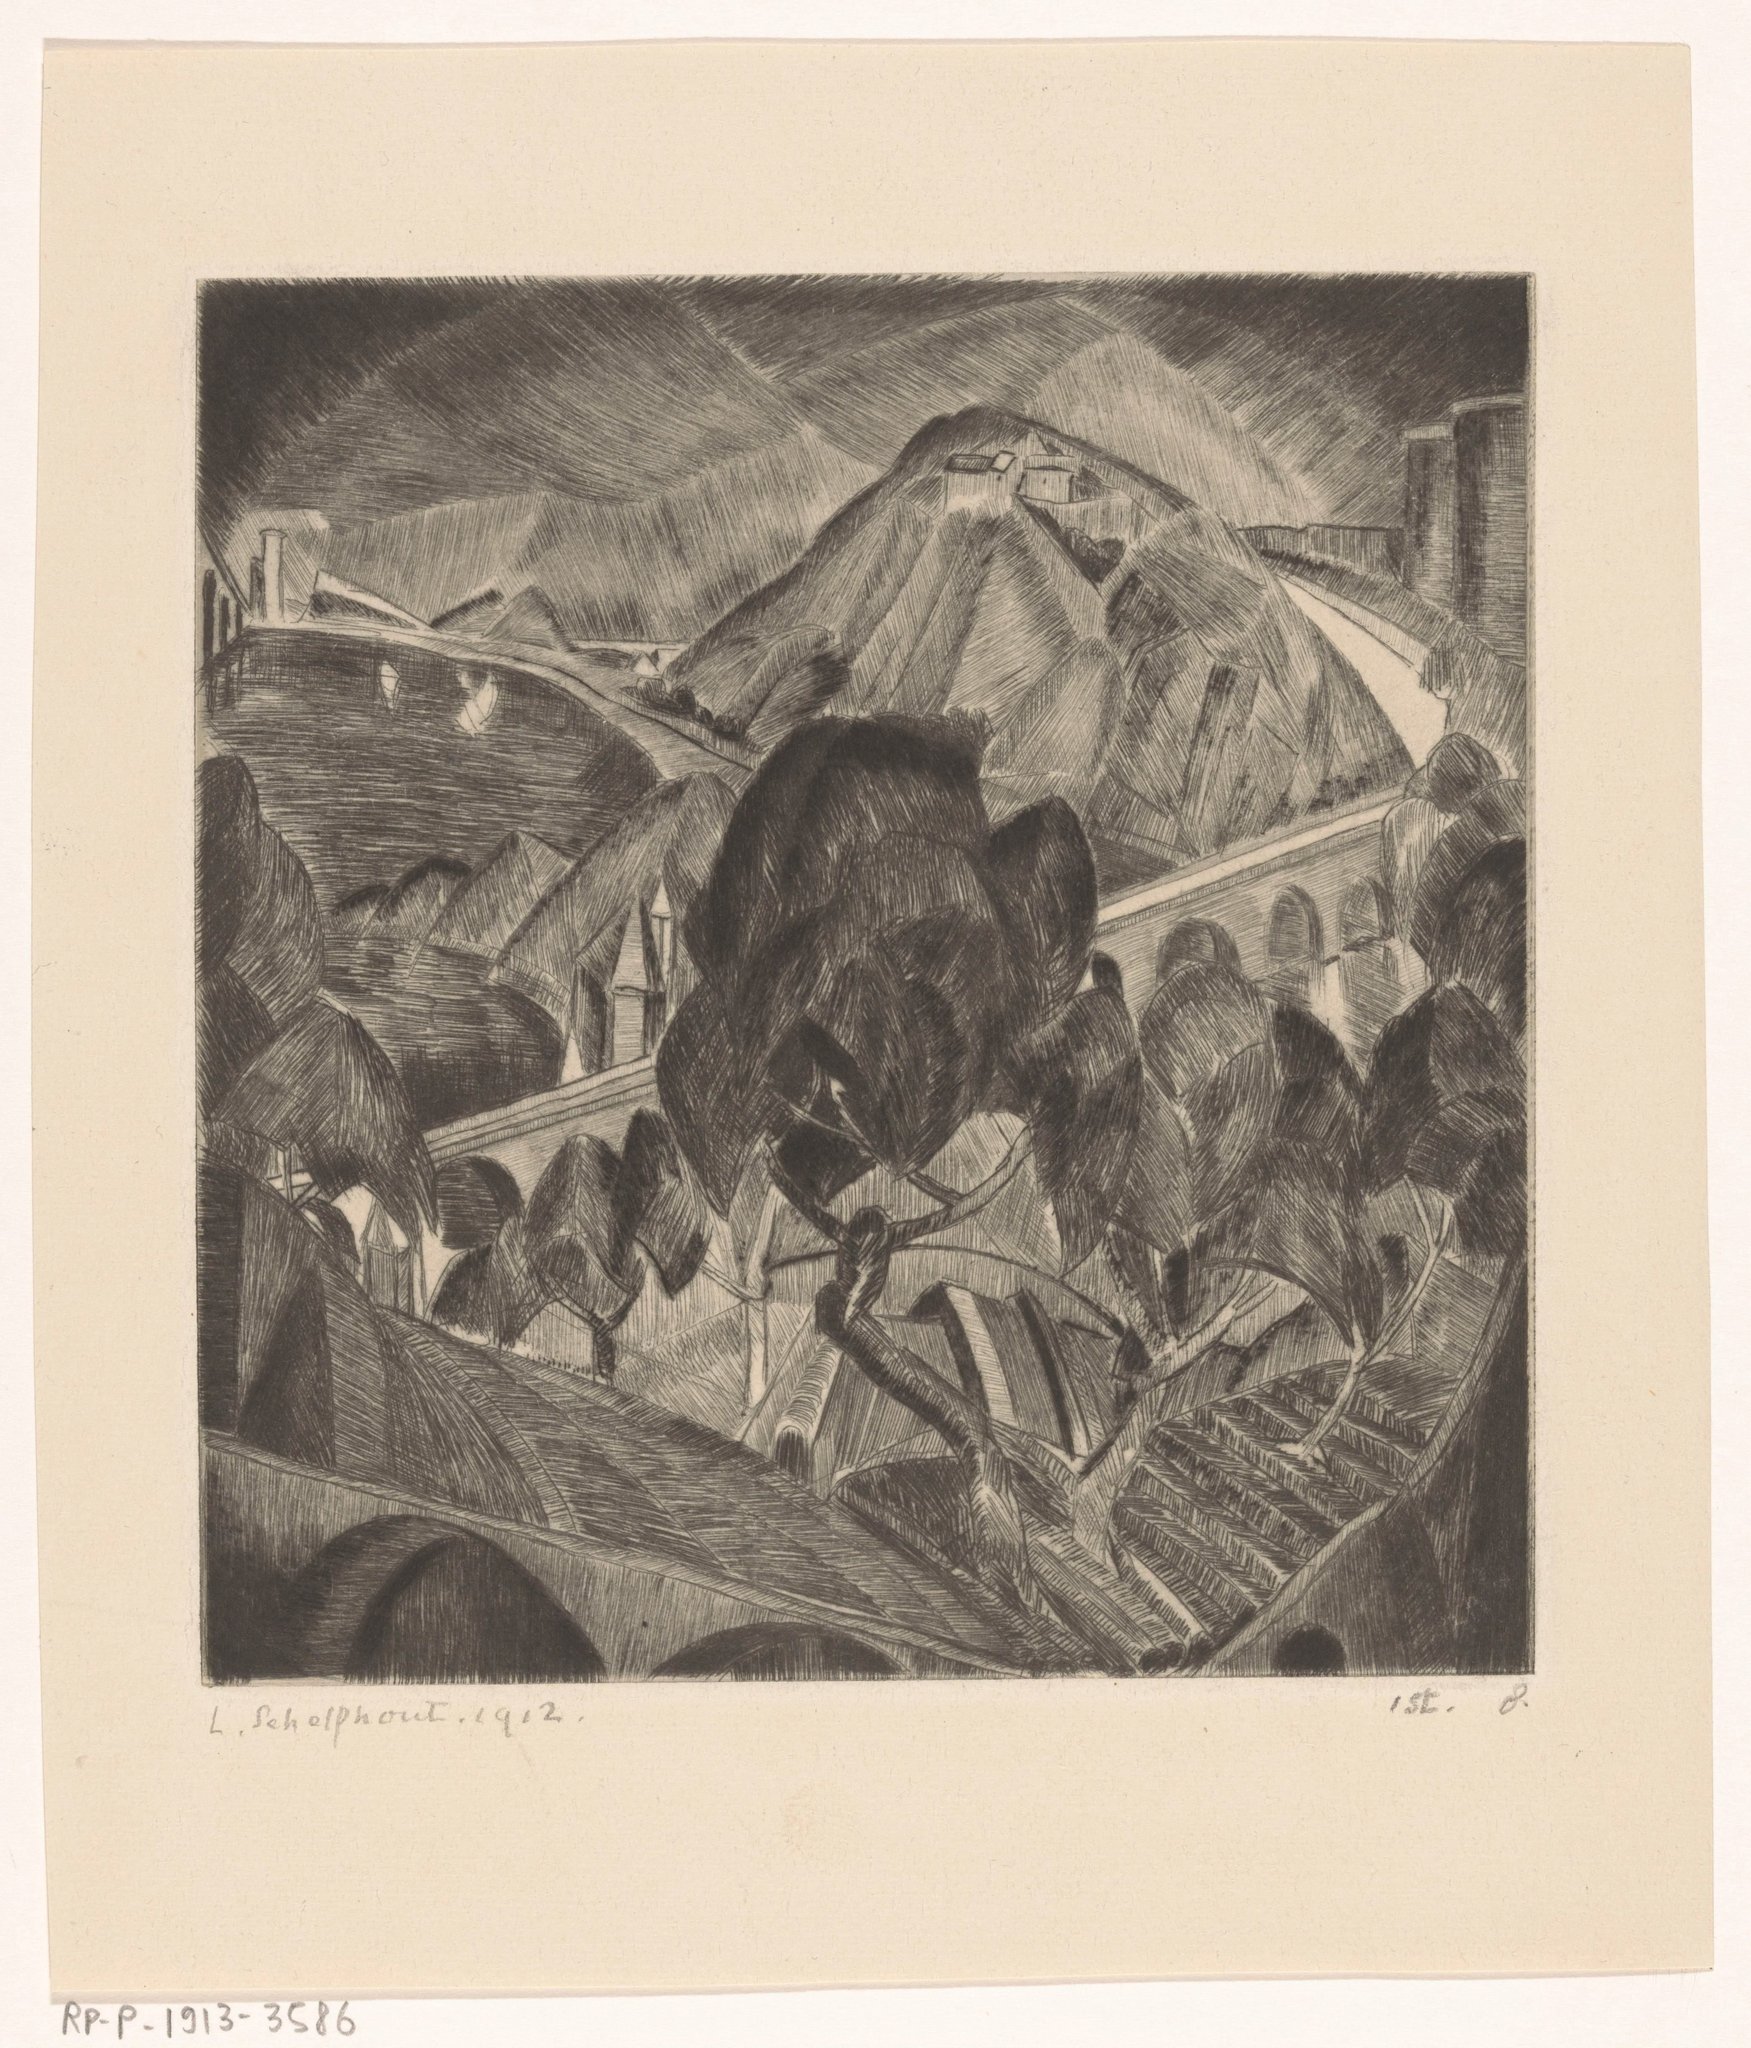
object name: print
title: L'Aqueduc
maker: lodewijk schelfhout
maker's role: draughtsman, print maker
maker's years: 1881-1943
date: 1912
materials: paper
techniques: drypoint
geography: paris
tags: aqueduct (~ water supply), mountains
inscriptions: number: ‘8’, collector's mark: Lugt 2233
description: Een berglandschap langs een baai. Op de voorgrond bomen en een aquaduct.